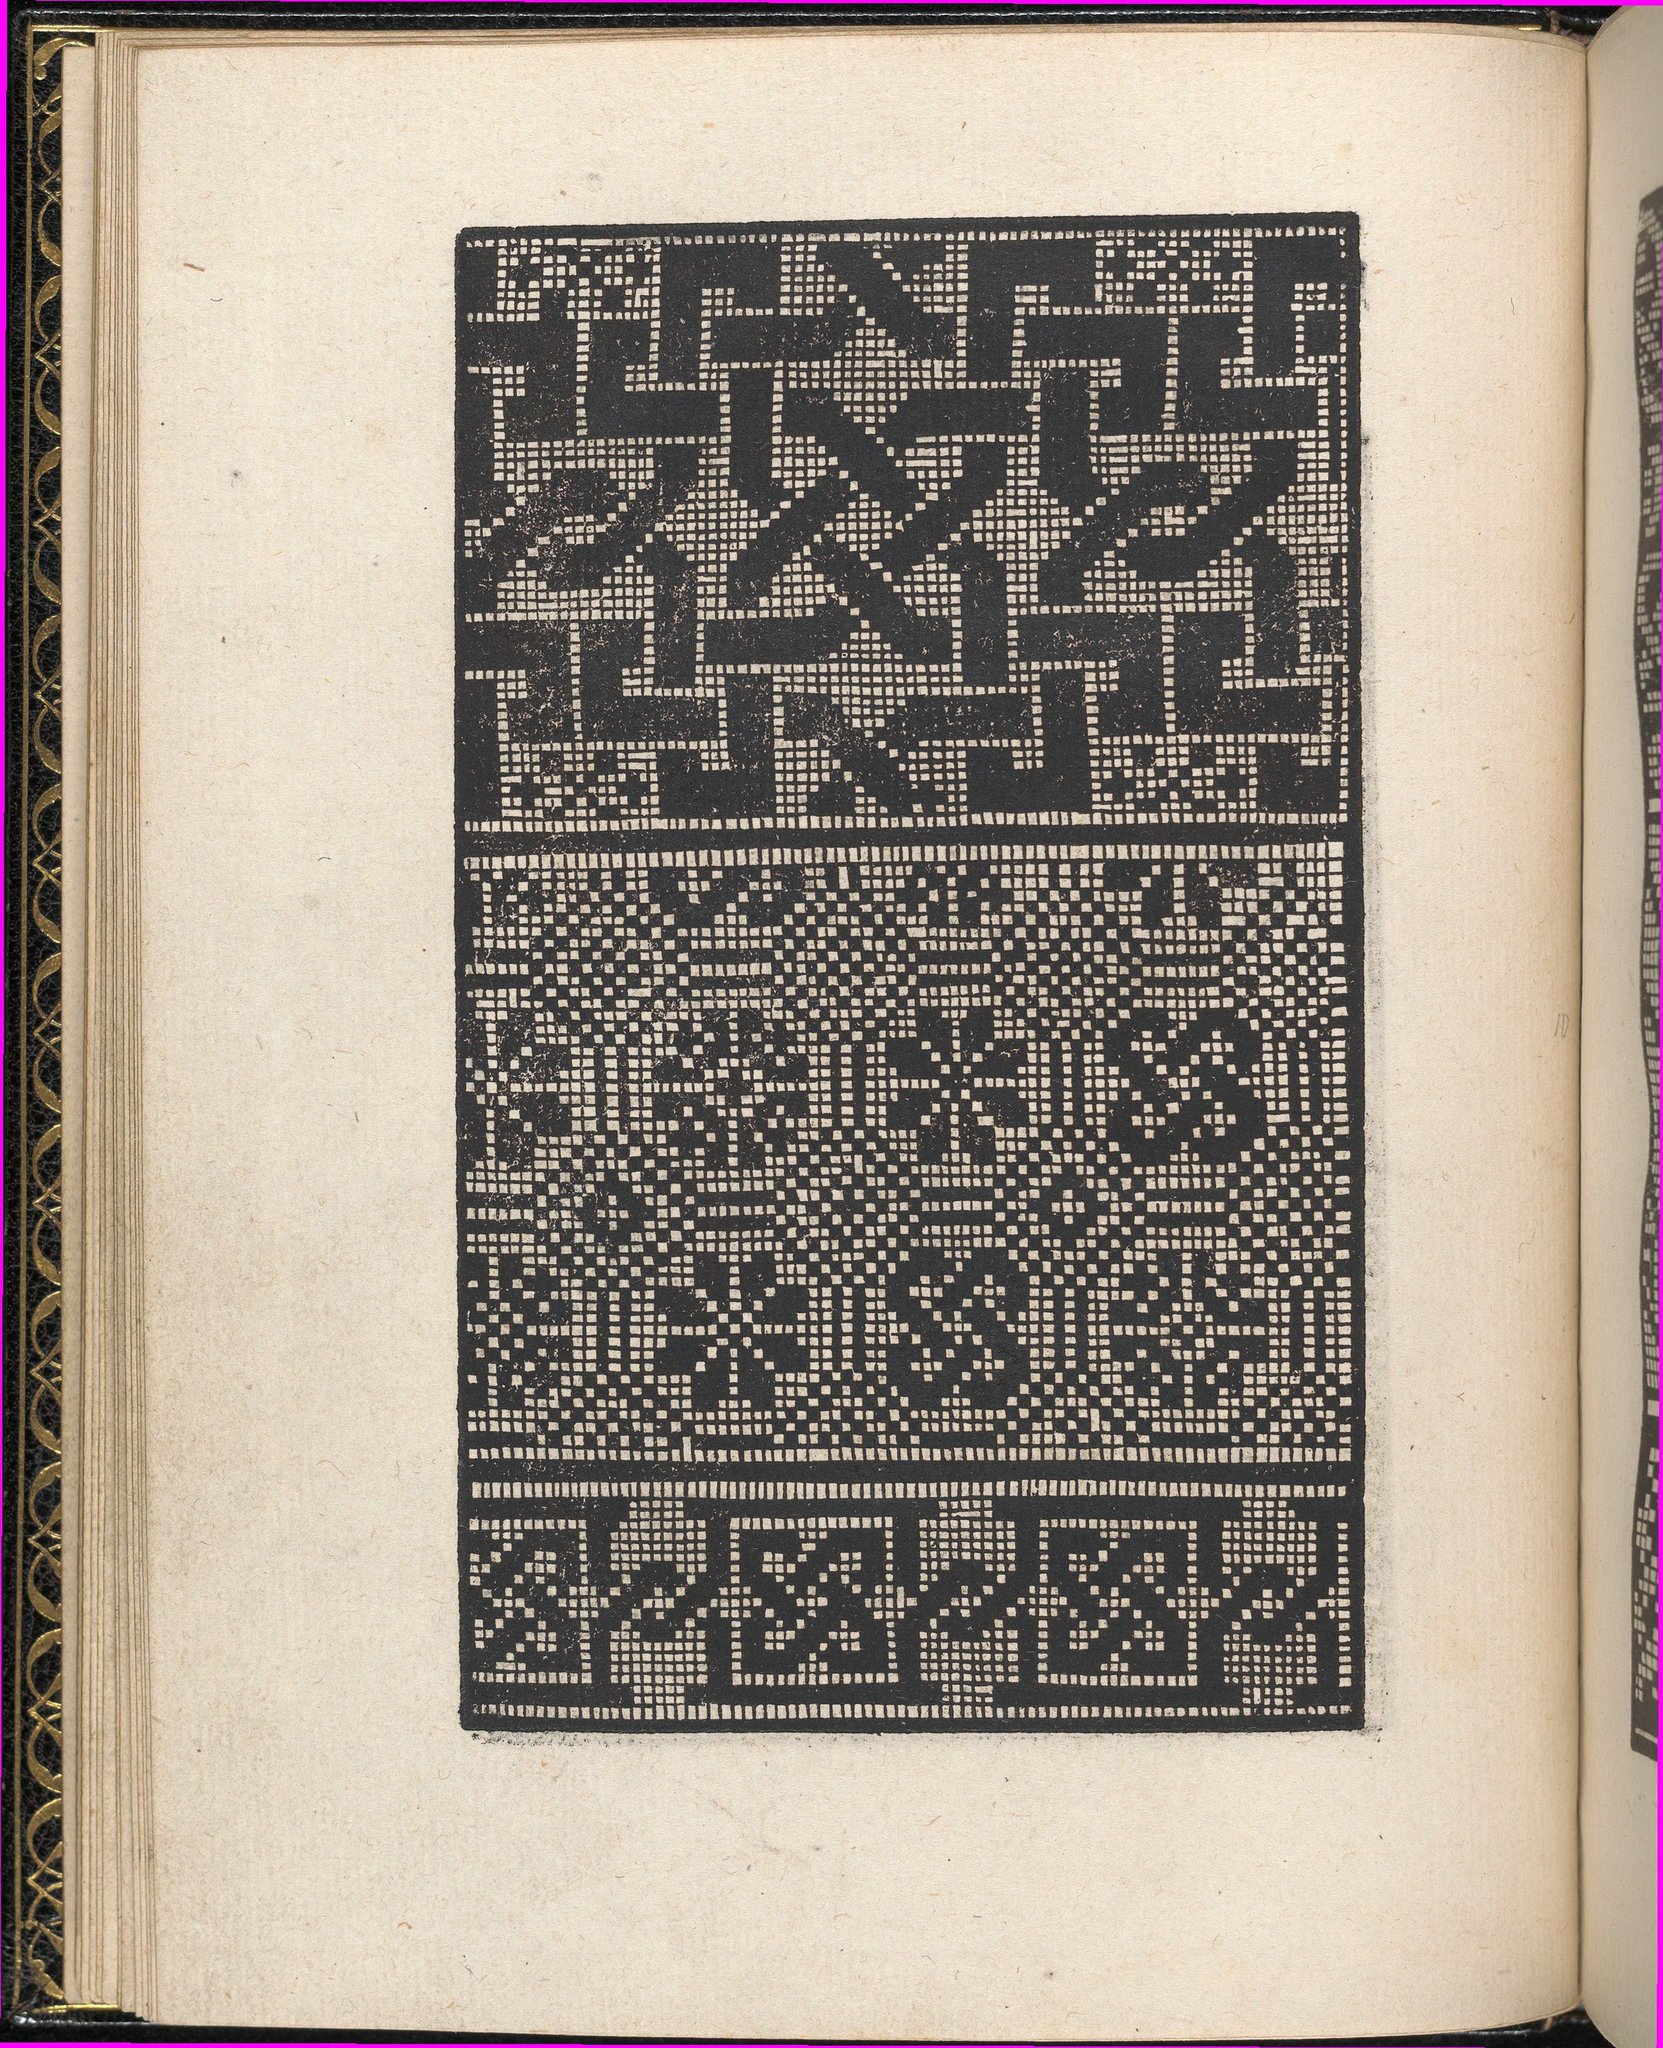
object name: book print ornament architecture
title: Page from Ein new kunstlich Modelbuch...(Page 10v)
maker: peter quentel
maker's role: publisher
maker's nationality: german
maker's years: 1500-1550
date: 1544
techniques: woodcut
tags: ornament